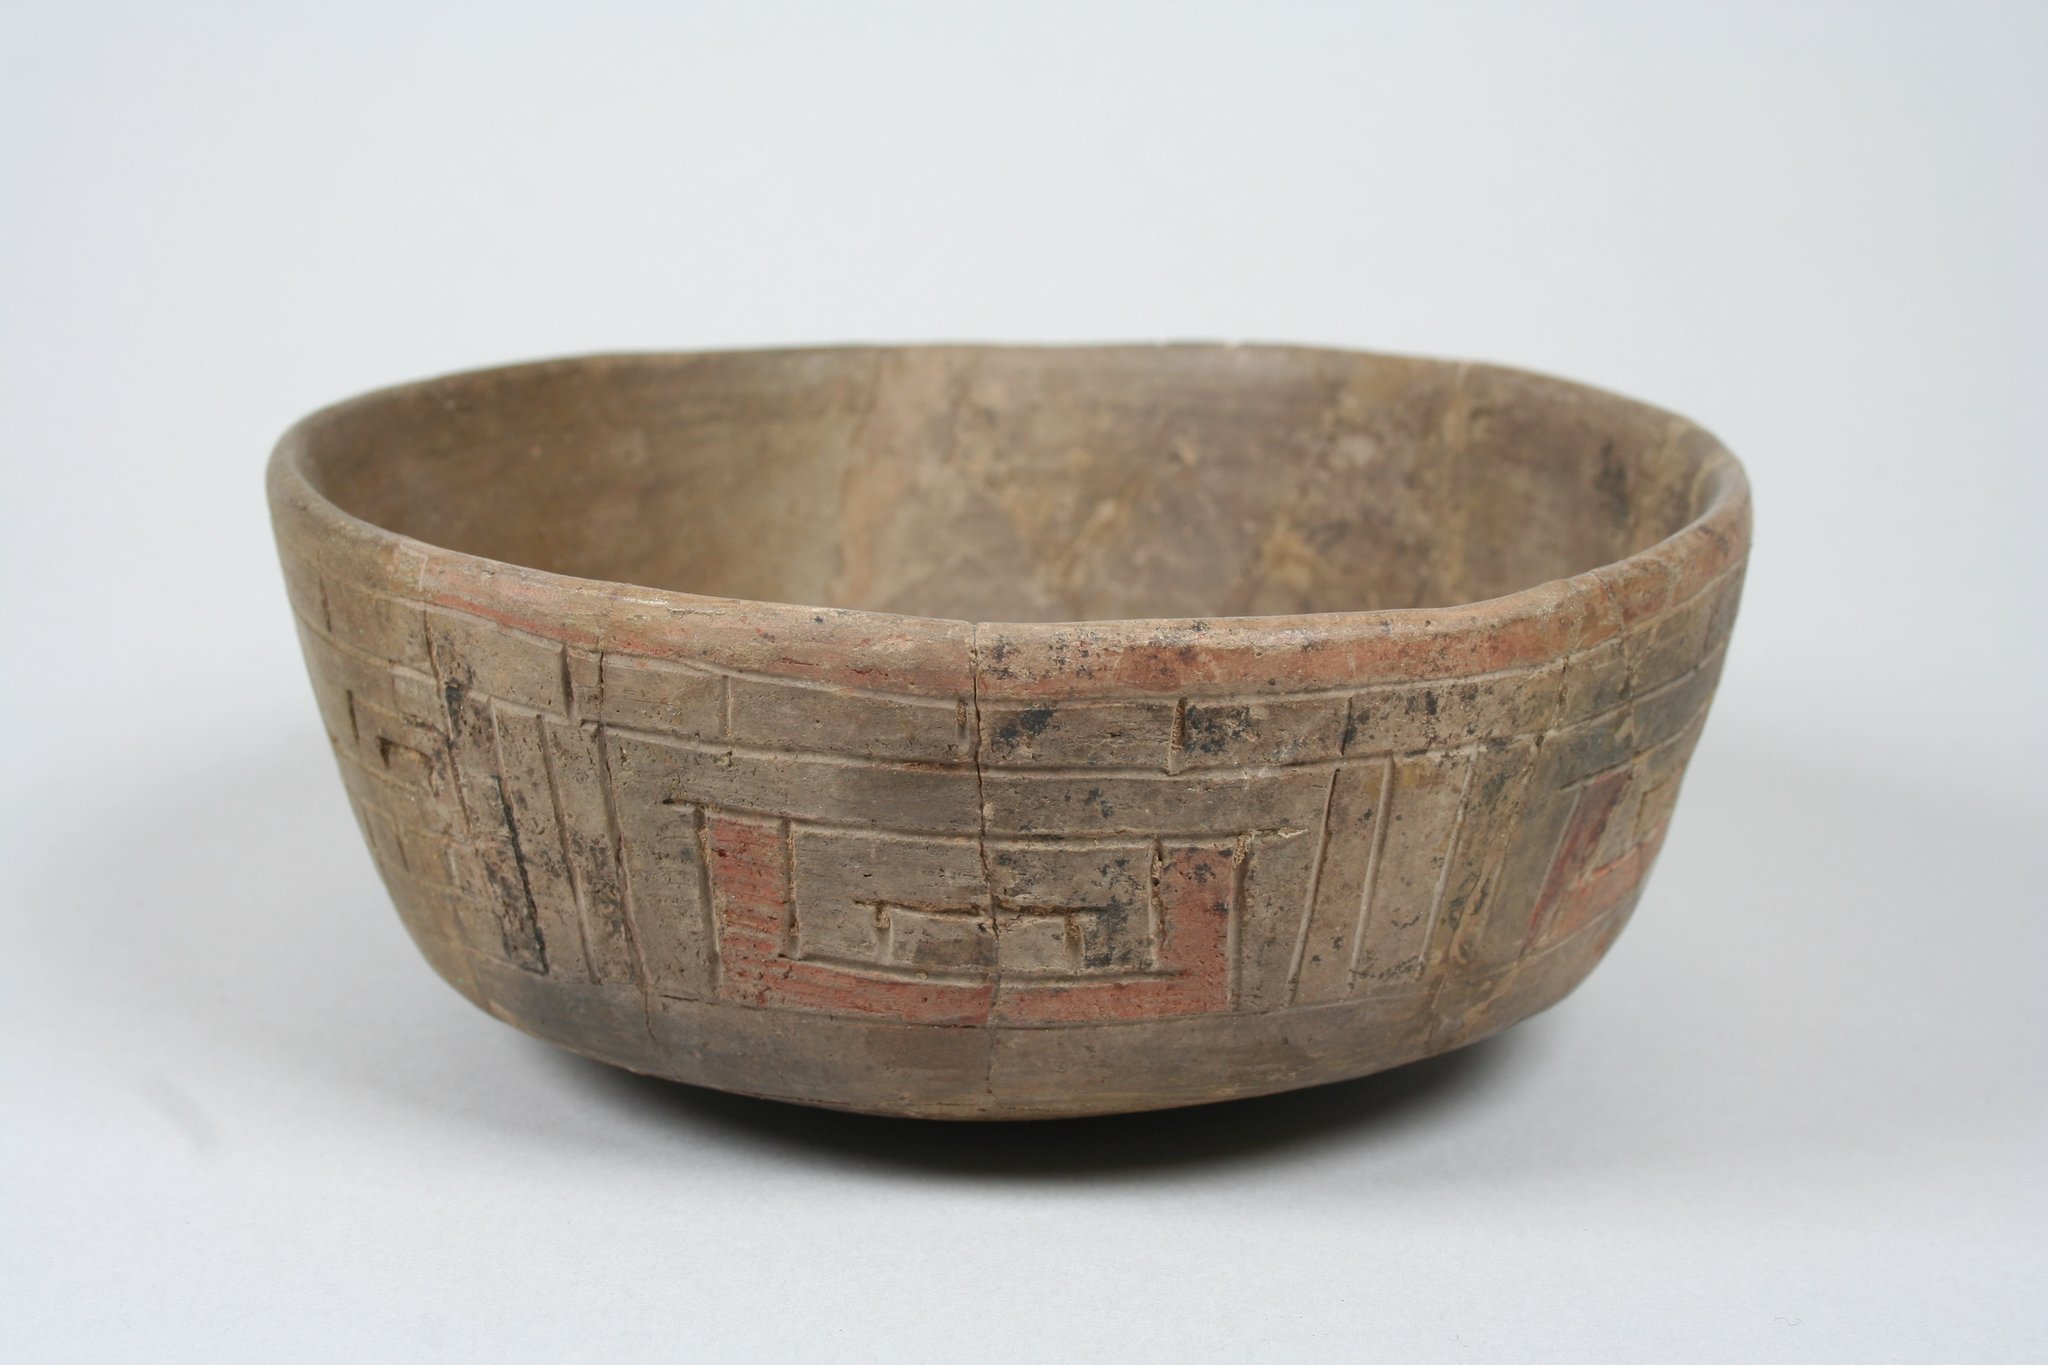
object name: bowl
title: Incised bowl with fox motif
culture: paracas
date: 700-401 BCE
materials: ceramic, pigment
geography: peru